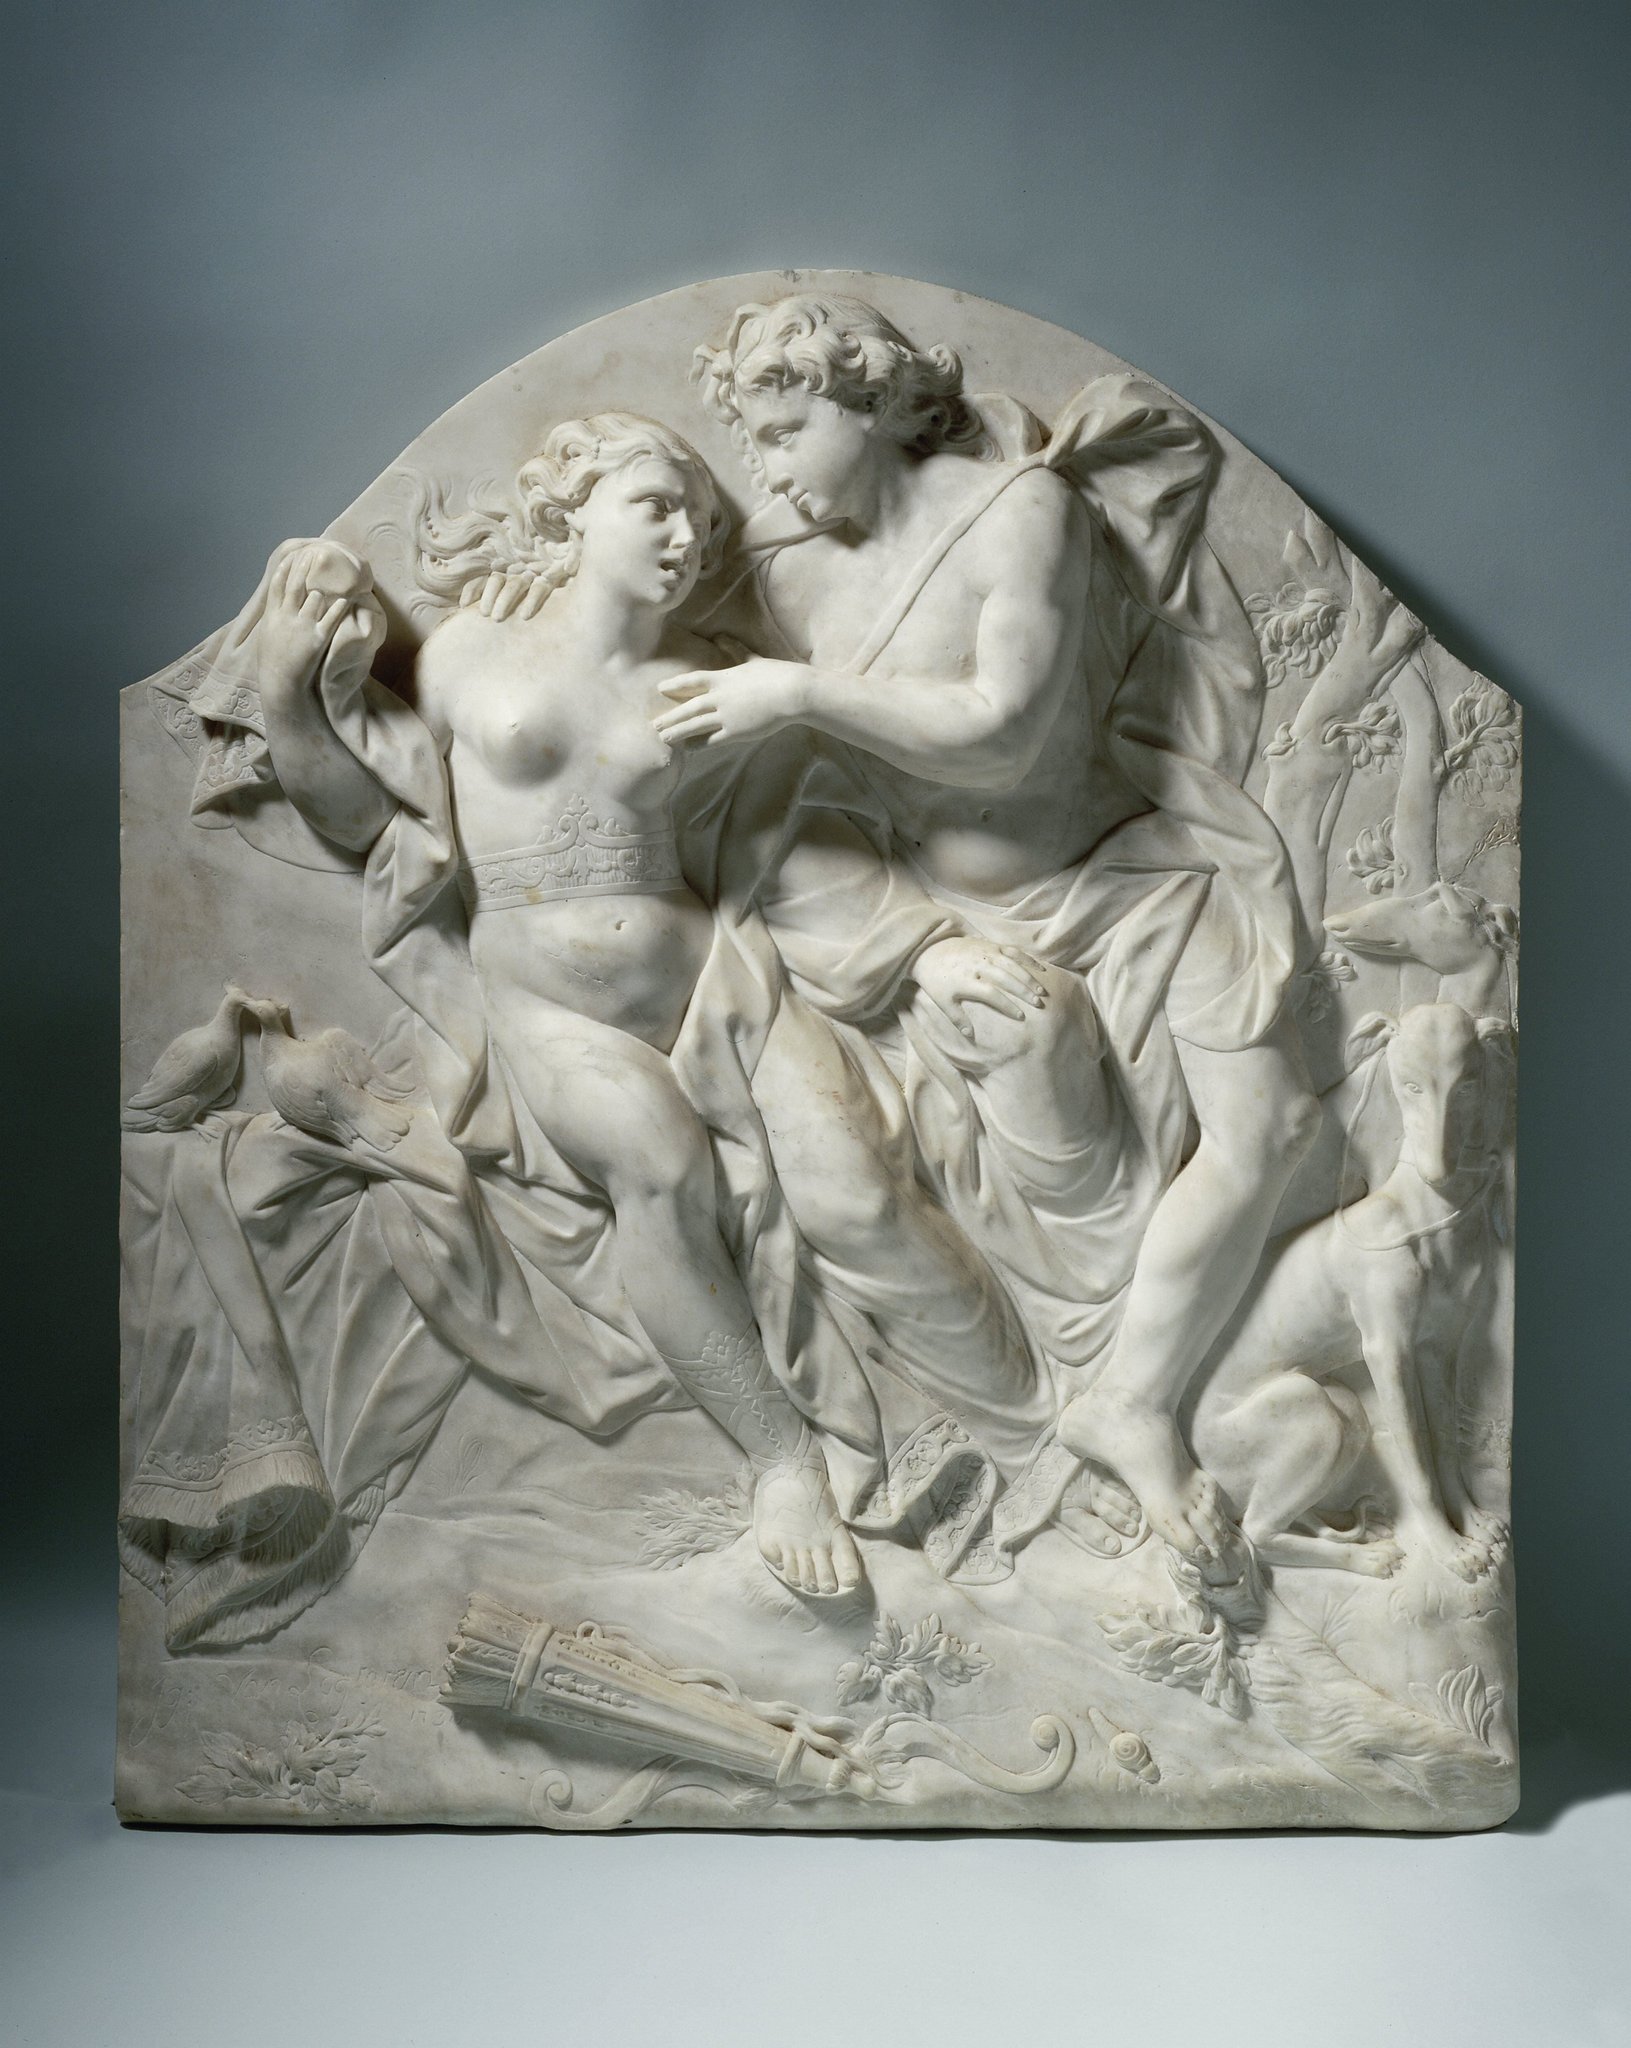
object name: sculpture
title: Chimney Piece with Venus and Adonis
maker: ignatius van logteren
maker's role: sculptor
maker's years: 1685-1732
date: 1730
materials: marble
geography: amsterdam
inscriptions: signature and date, below left, incised: ‘Ig. Van Logteren 1730’